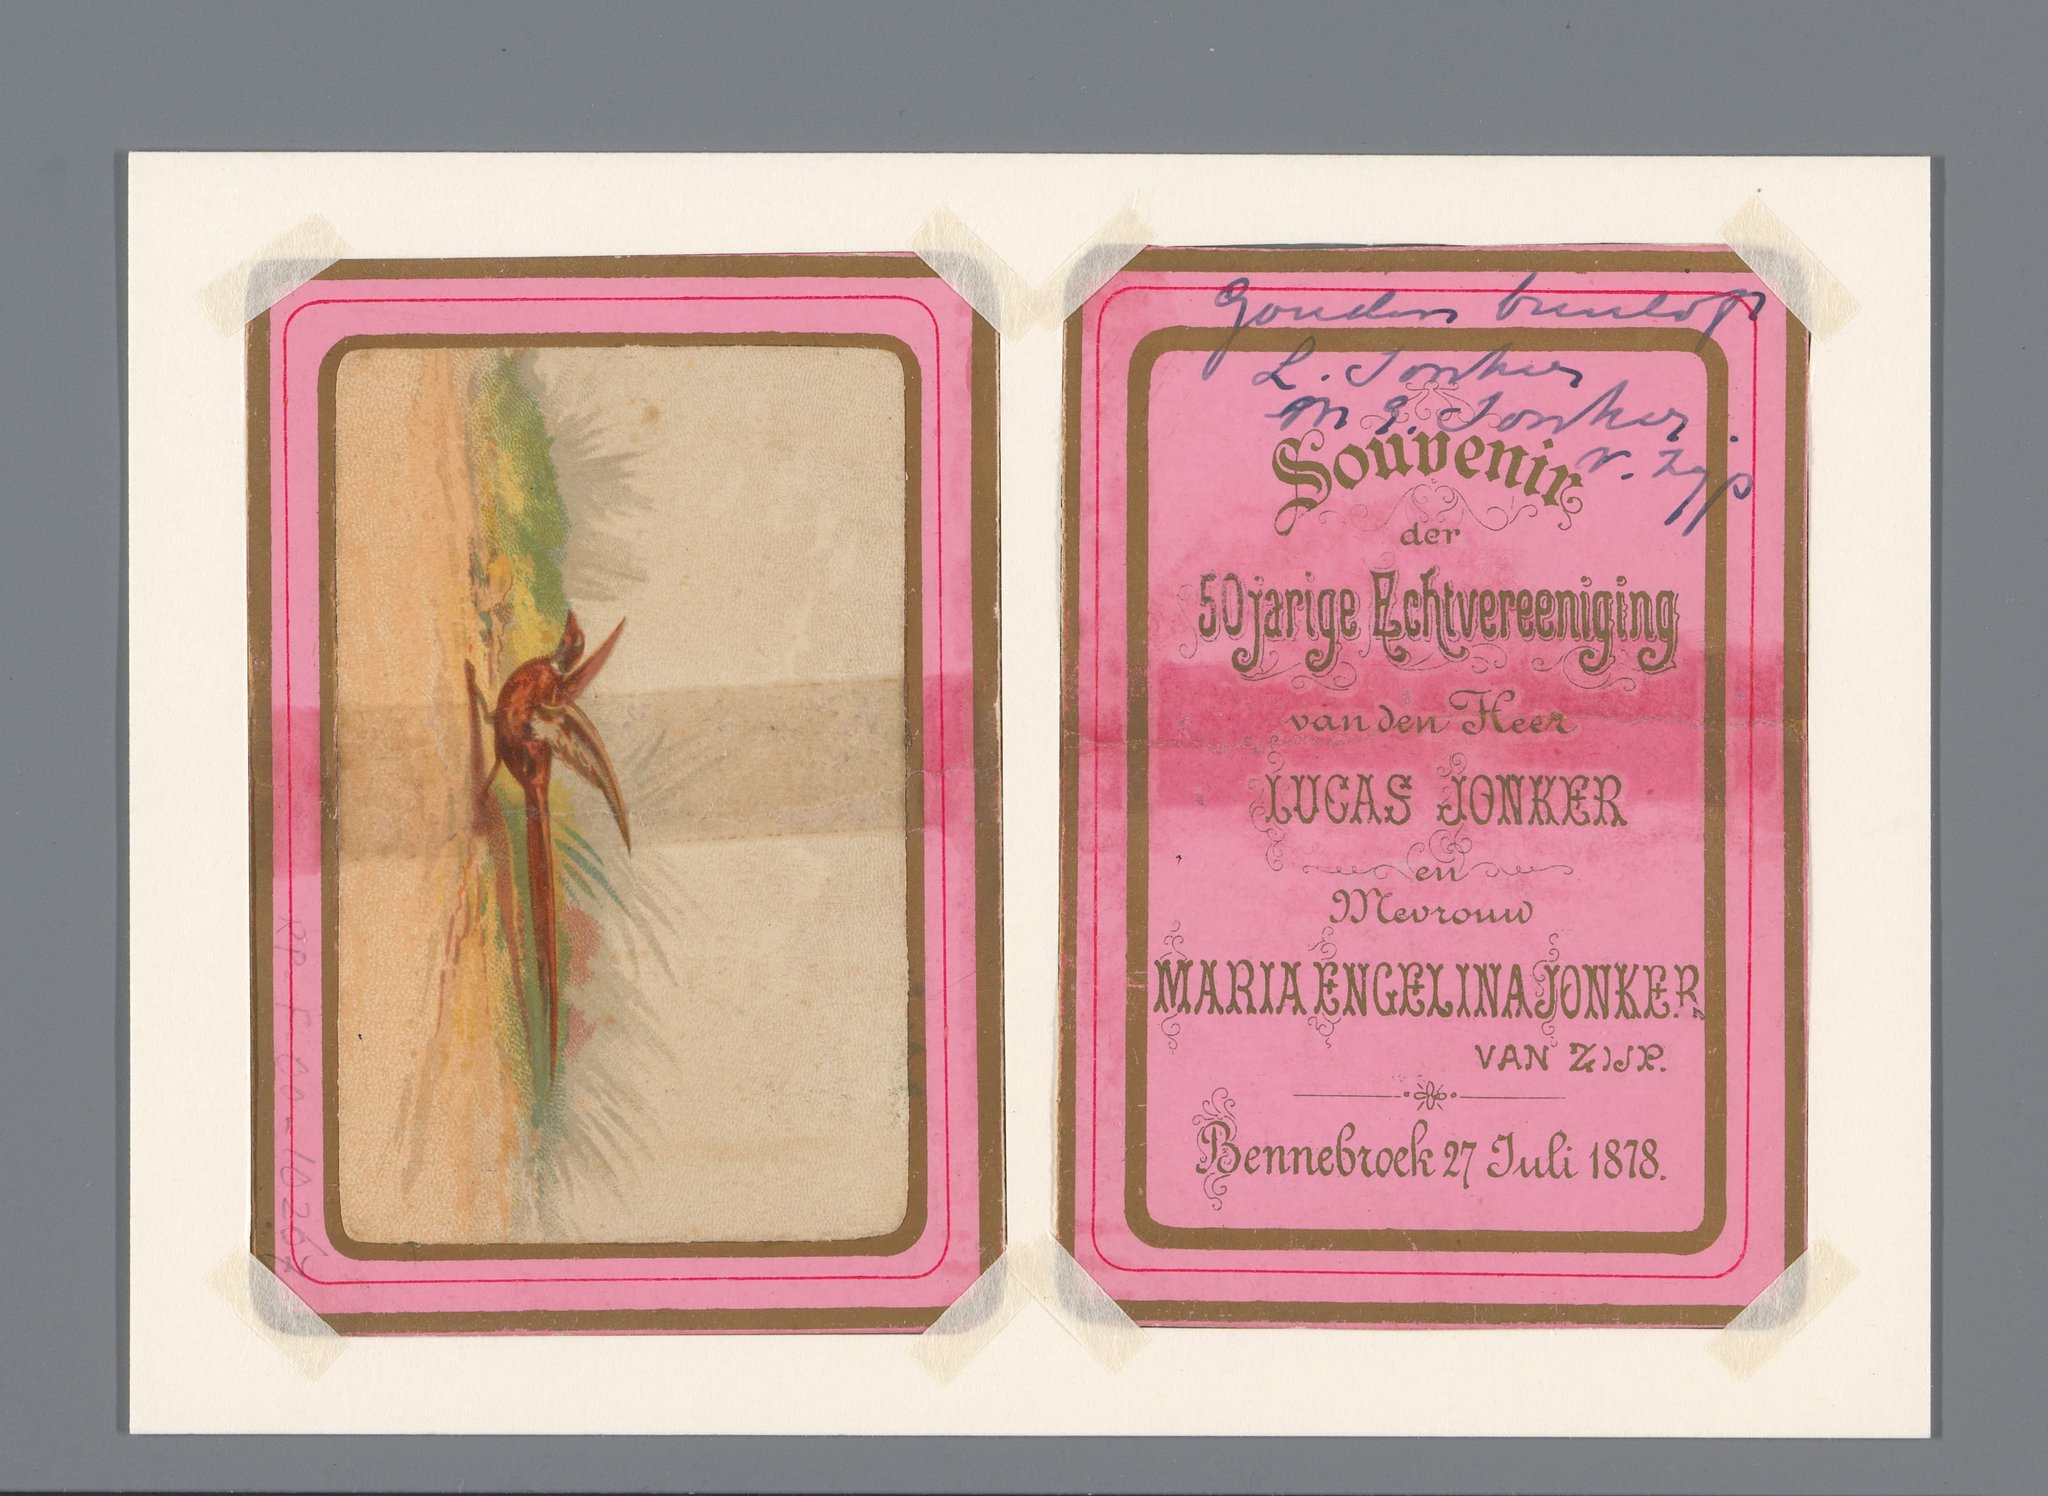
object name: photograph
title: Portretten van Lucas Jonker en Maria Engelina Jonker van Zijp en hun woning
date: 1877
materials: cardboard, photographic support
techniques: albumen print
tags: historical persons, façade (of house or building)